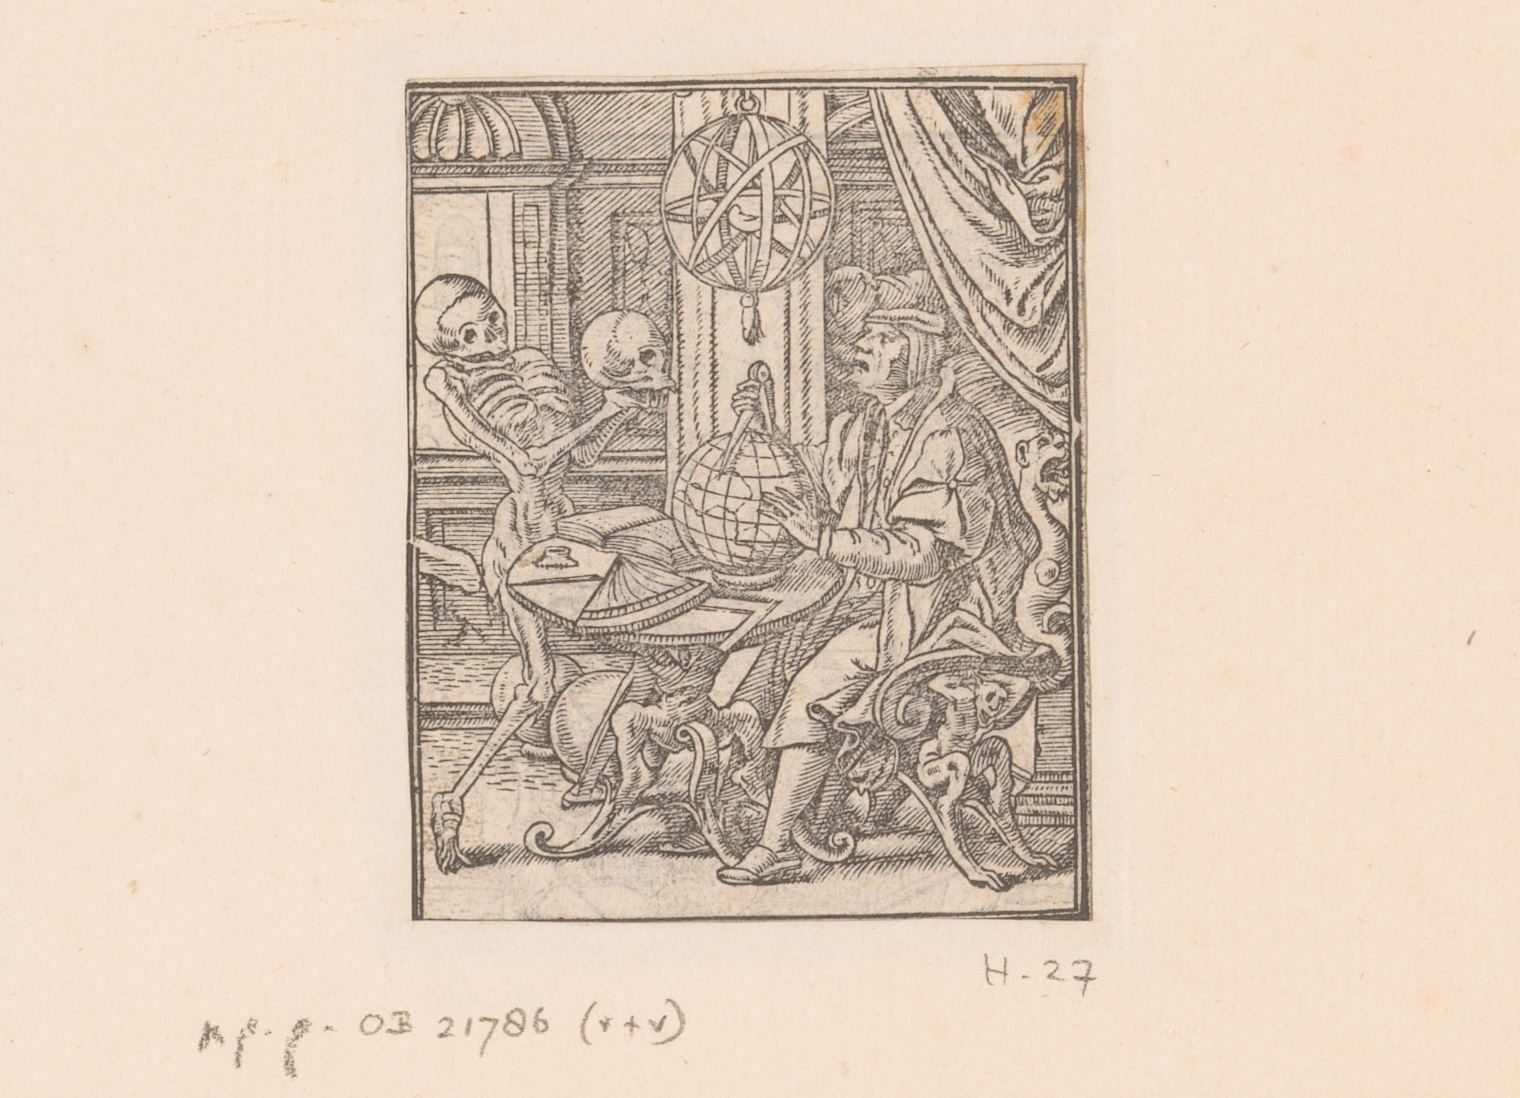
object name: print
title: Kopieën naar Holbeins Dodendans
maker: Anonymous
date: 1547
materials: paper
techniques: woodcut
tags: dance of death; death together with one or more human beings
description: Kopie van een prent van Hans Holbein de jongere uit 1538, voor het eerst gepubliceerd in: Imagines mortis (...). Lyon: Johannes Frellon, 1547.